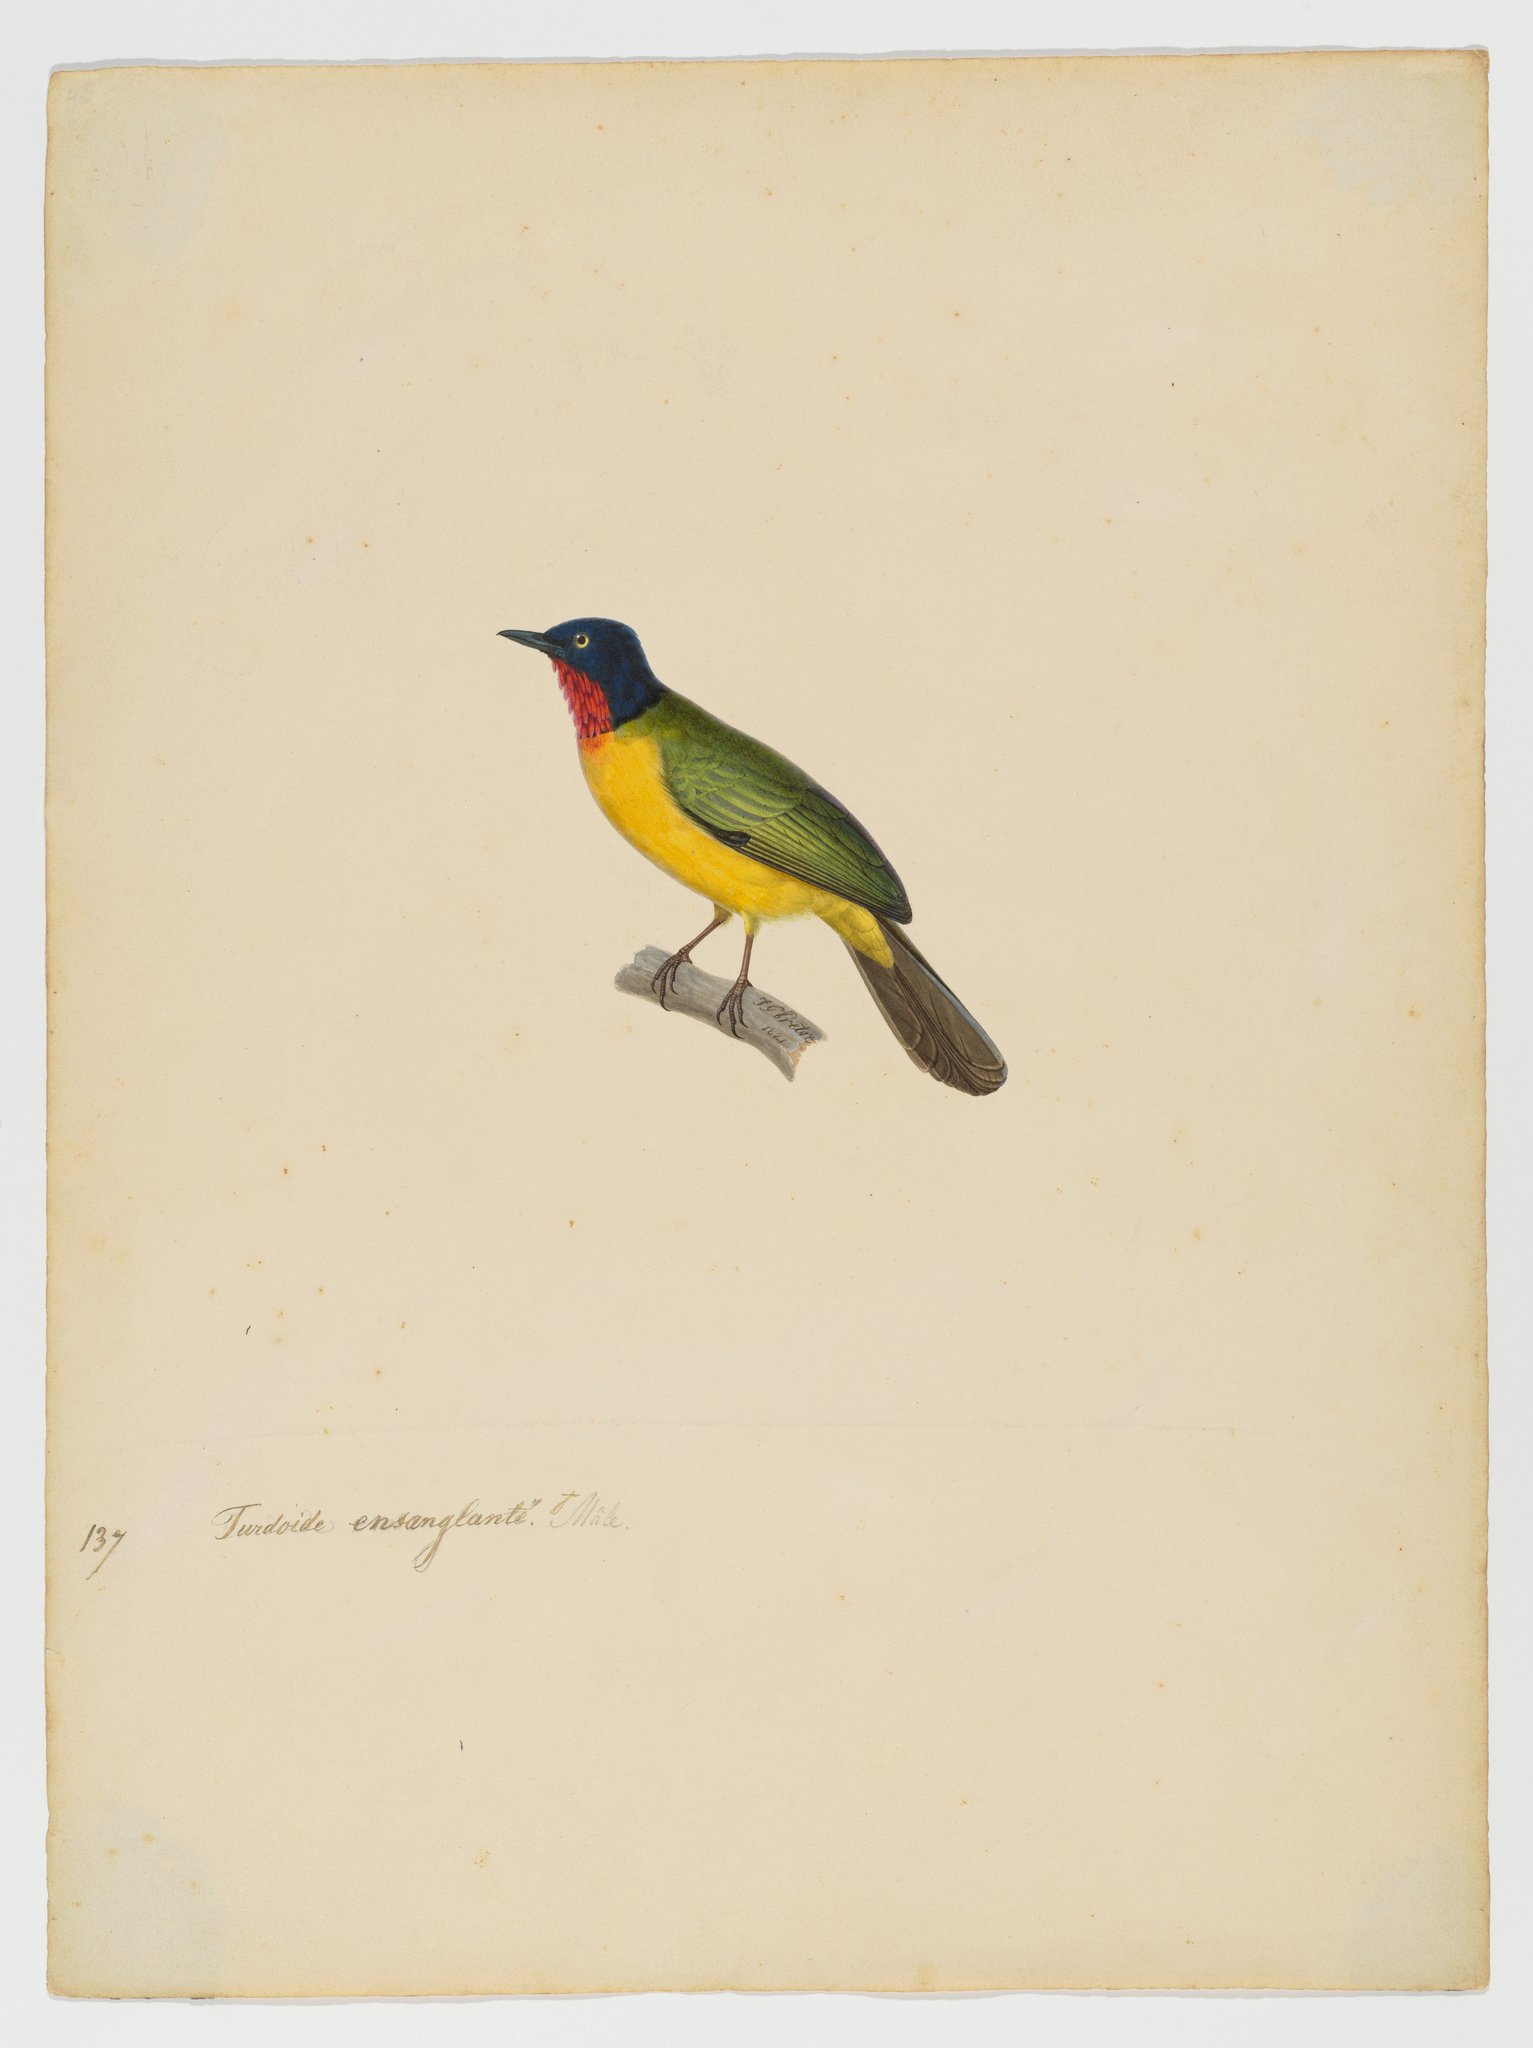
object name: drawing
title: Turdoide ensanglanté, male [current name: Flame-throated Bulbul. Rubigula gularis]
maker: jean-gabriel prêtre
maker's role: artist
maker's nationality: swiss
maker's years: 1768-1849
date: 1821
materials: gouache, watercolor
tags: birds